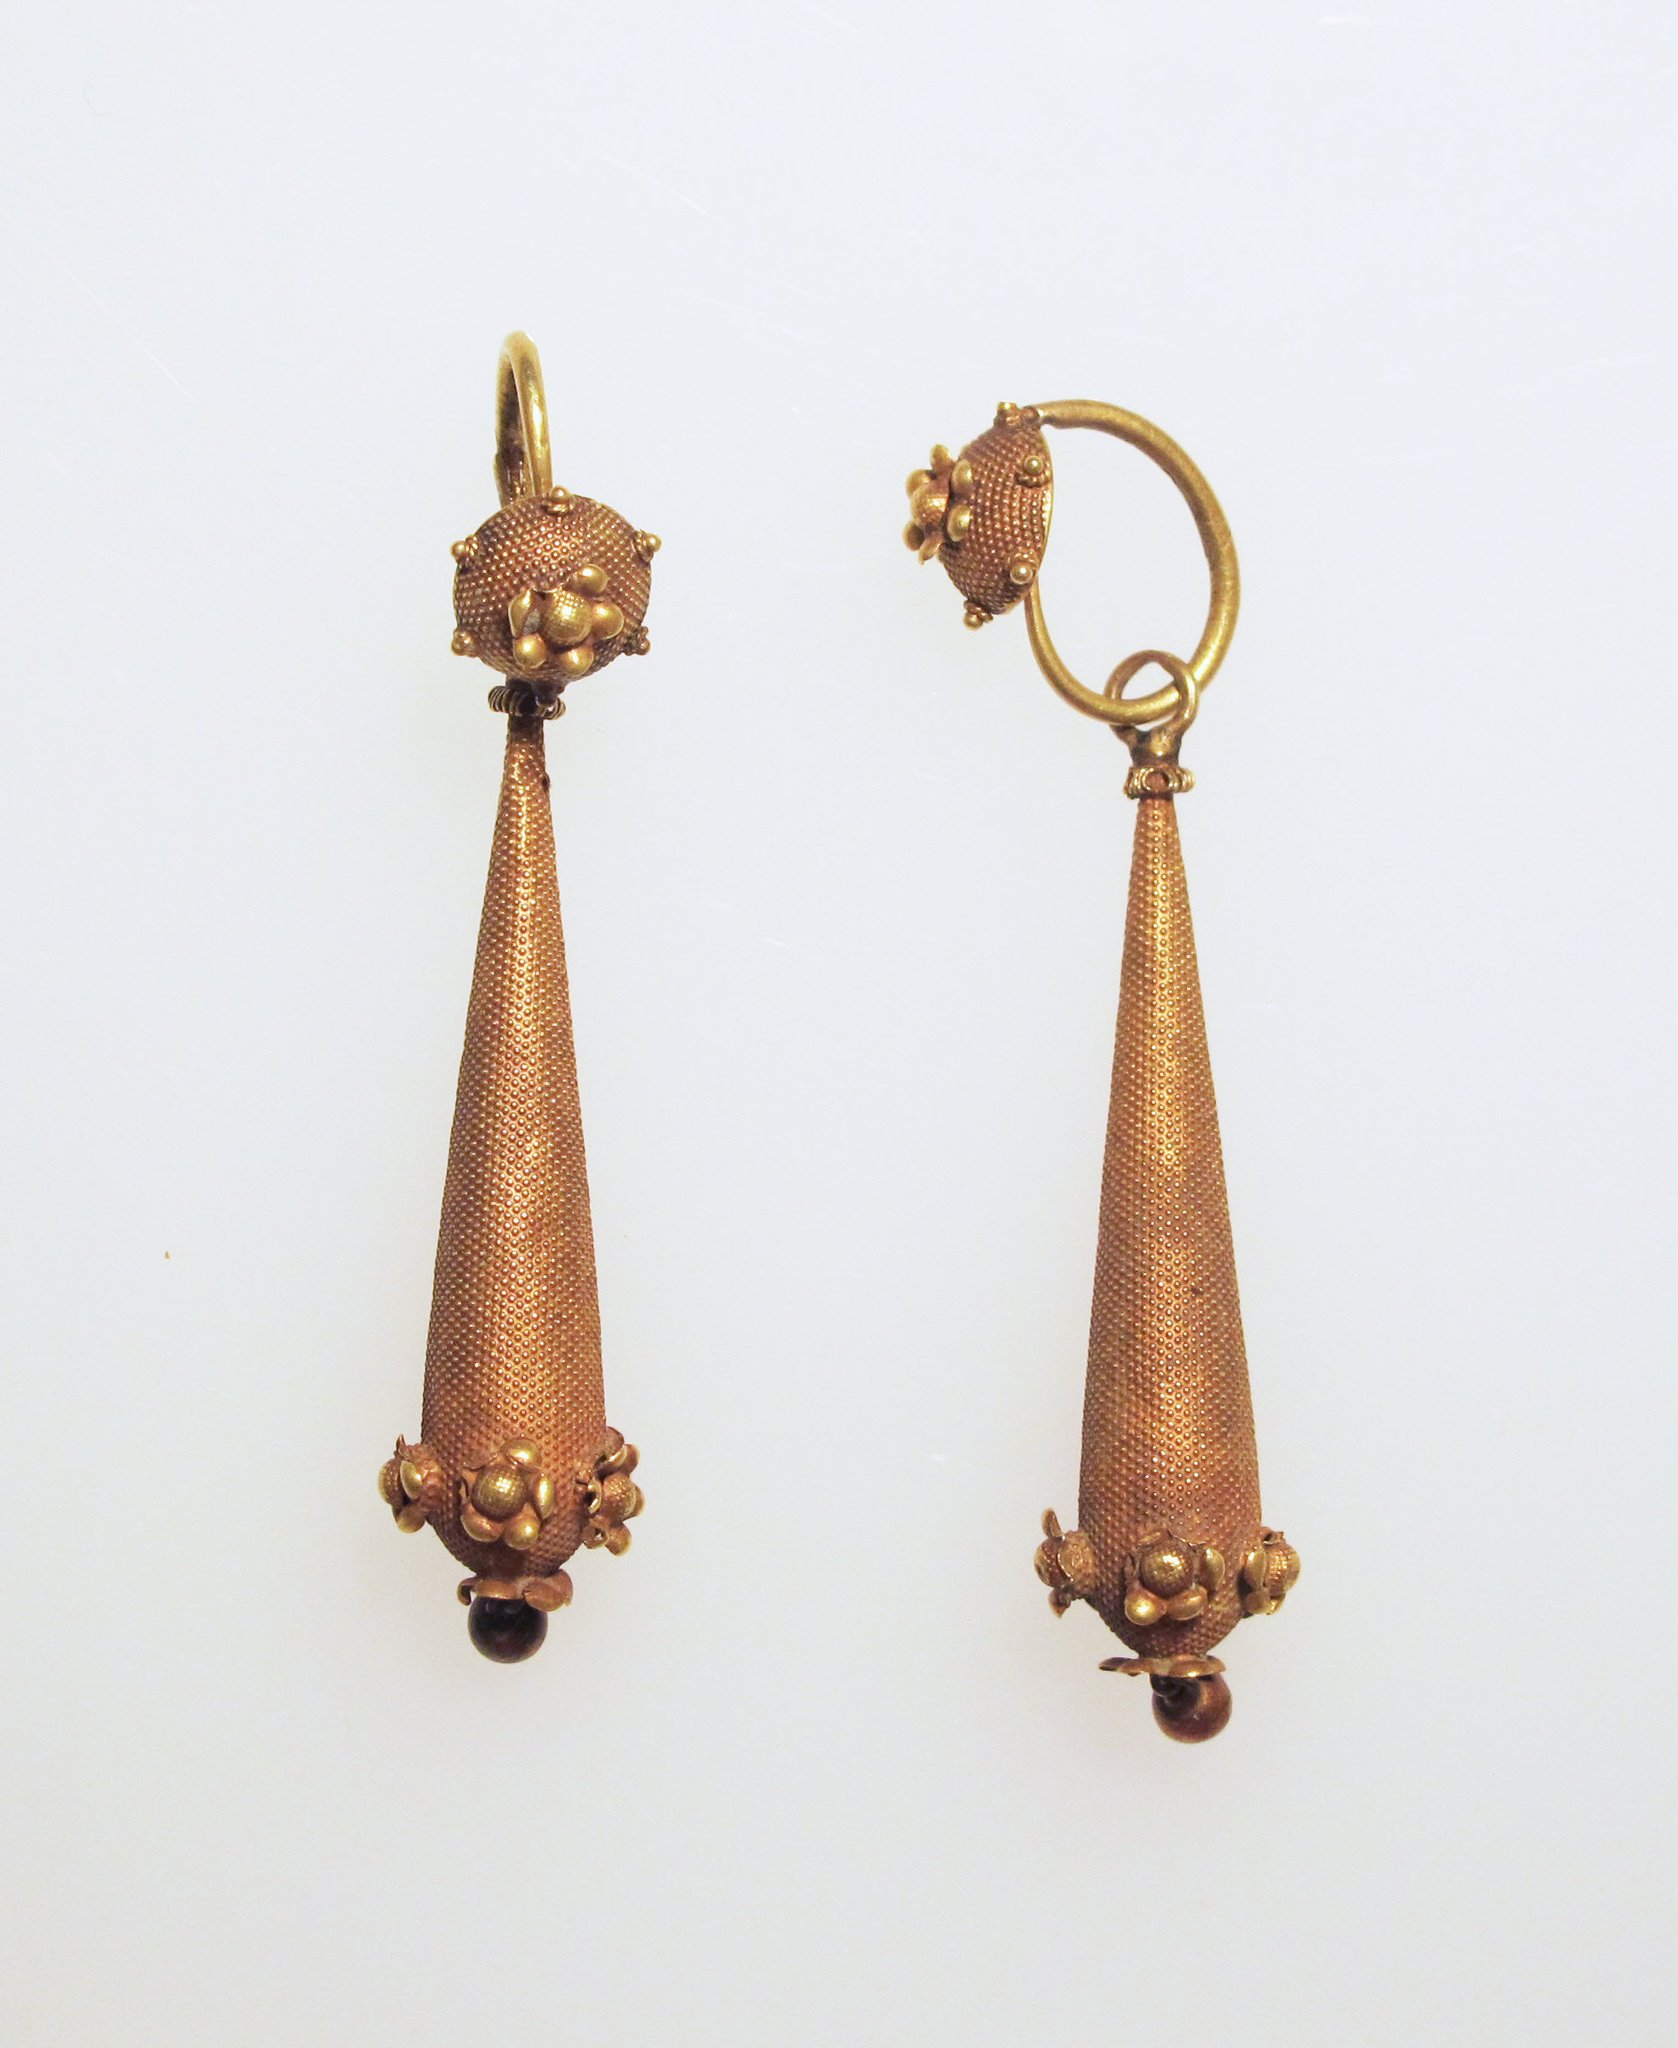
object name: earring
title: Earring rosette and pendant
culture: greek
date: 323 BCE-31 CE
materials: gold